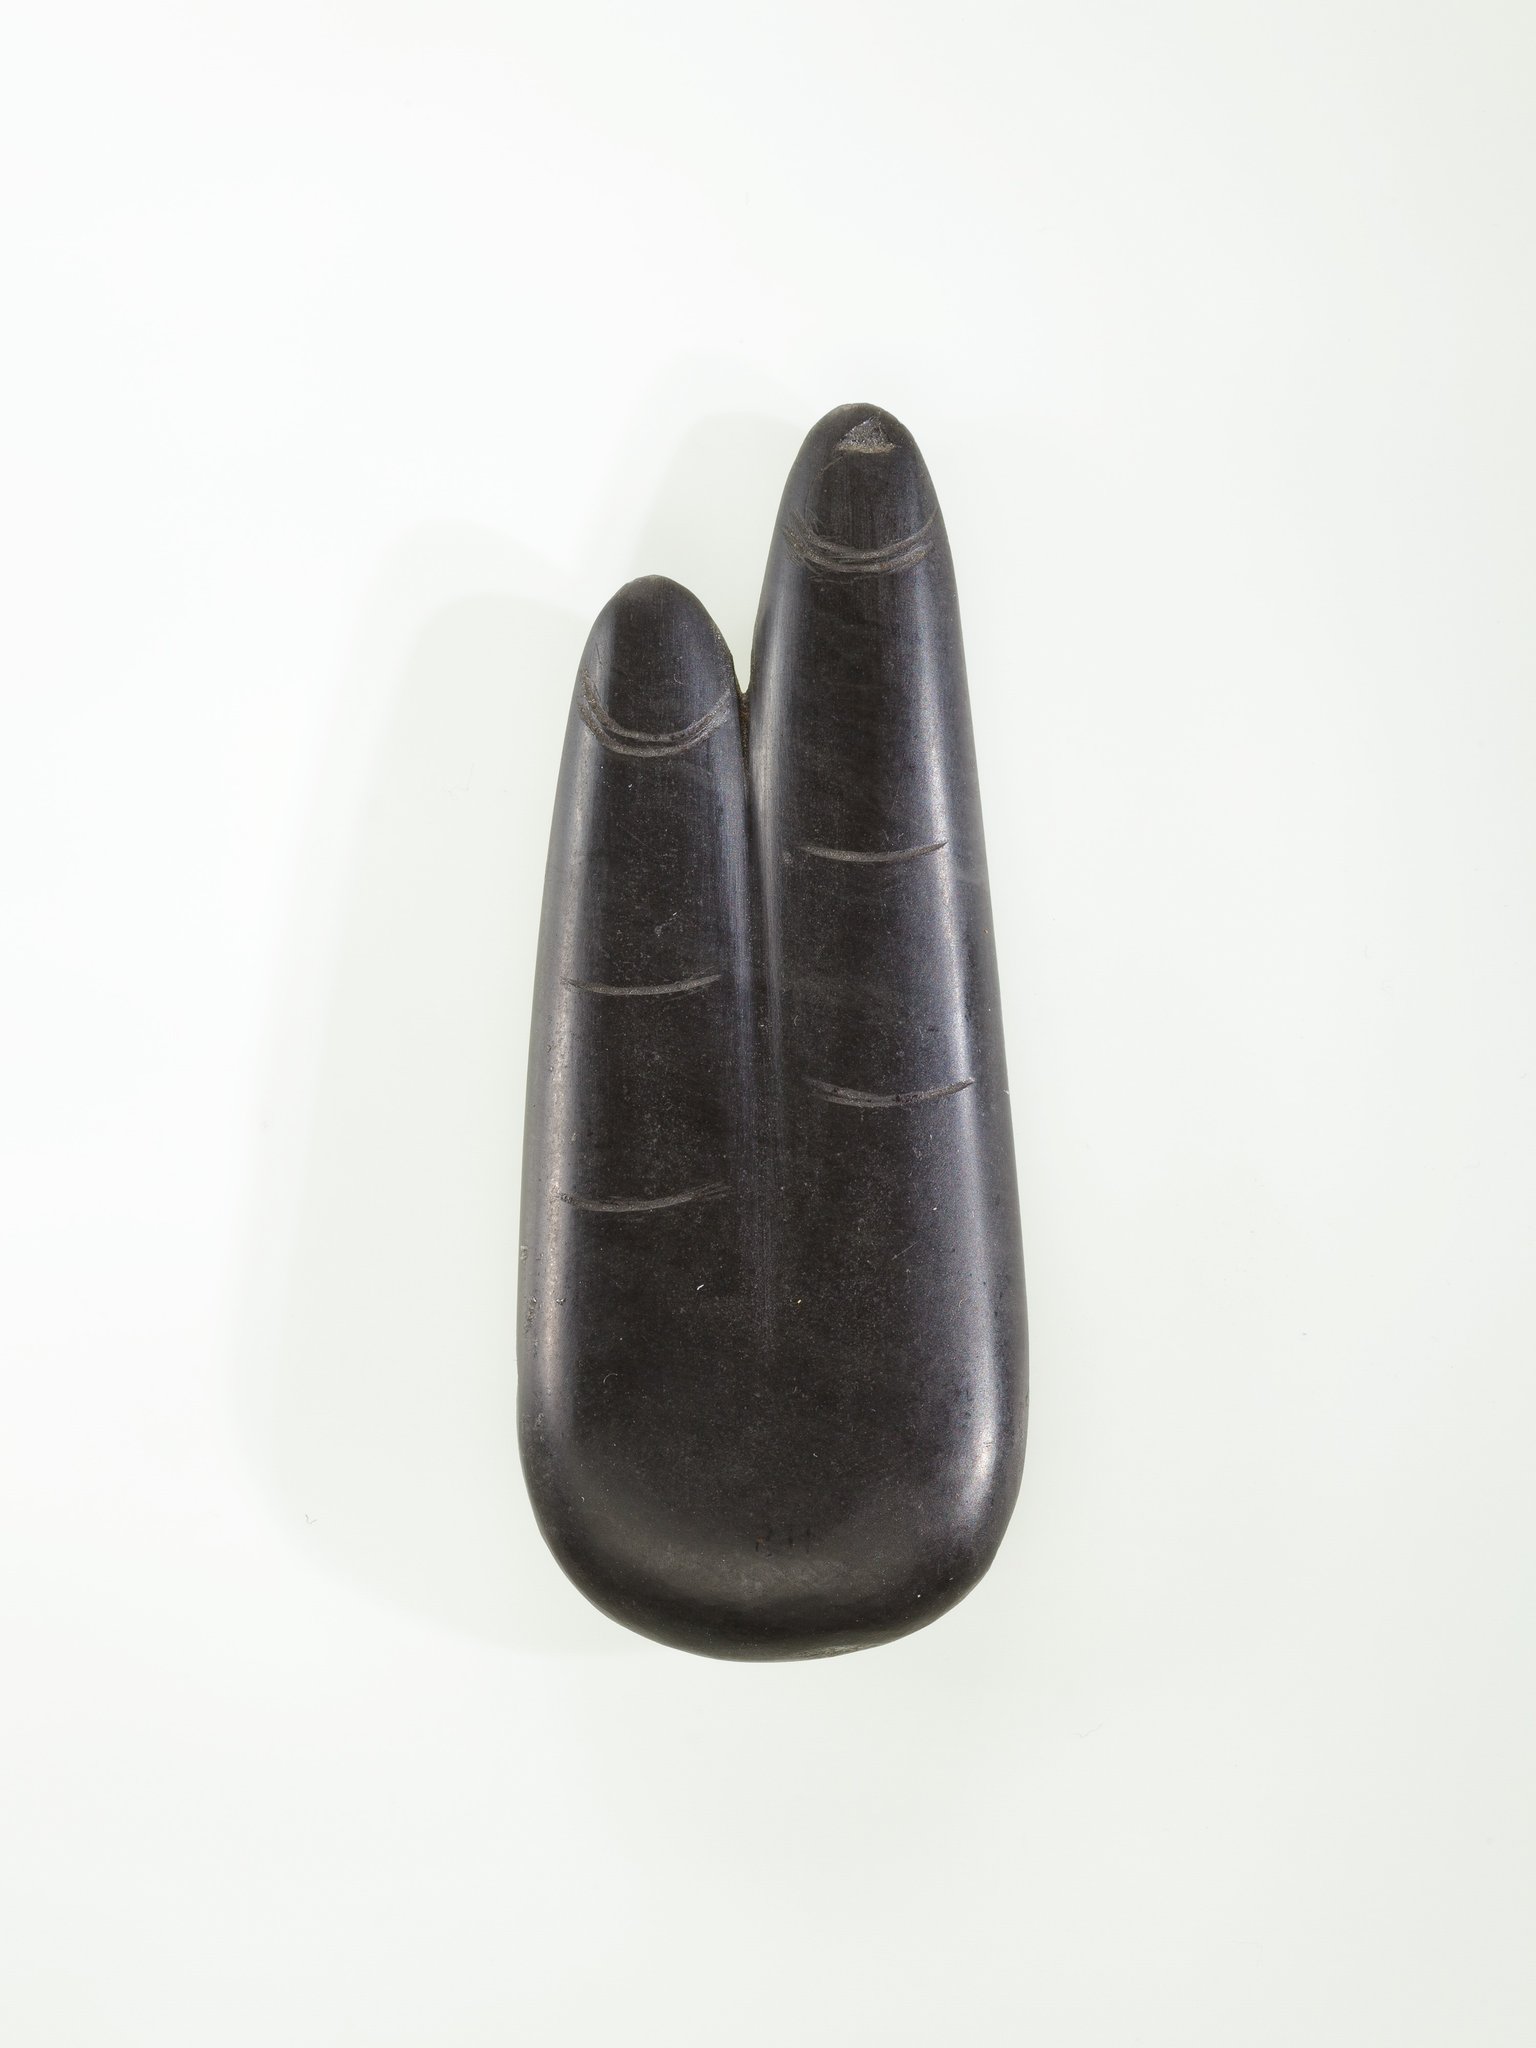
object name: amulet, two finger amulet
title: Two-finger amulet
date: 664-332 BCE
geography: egypt